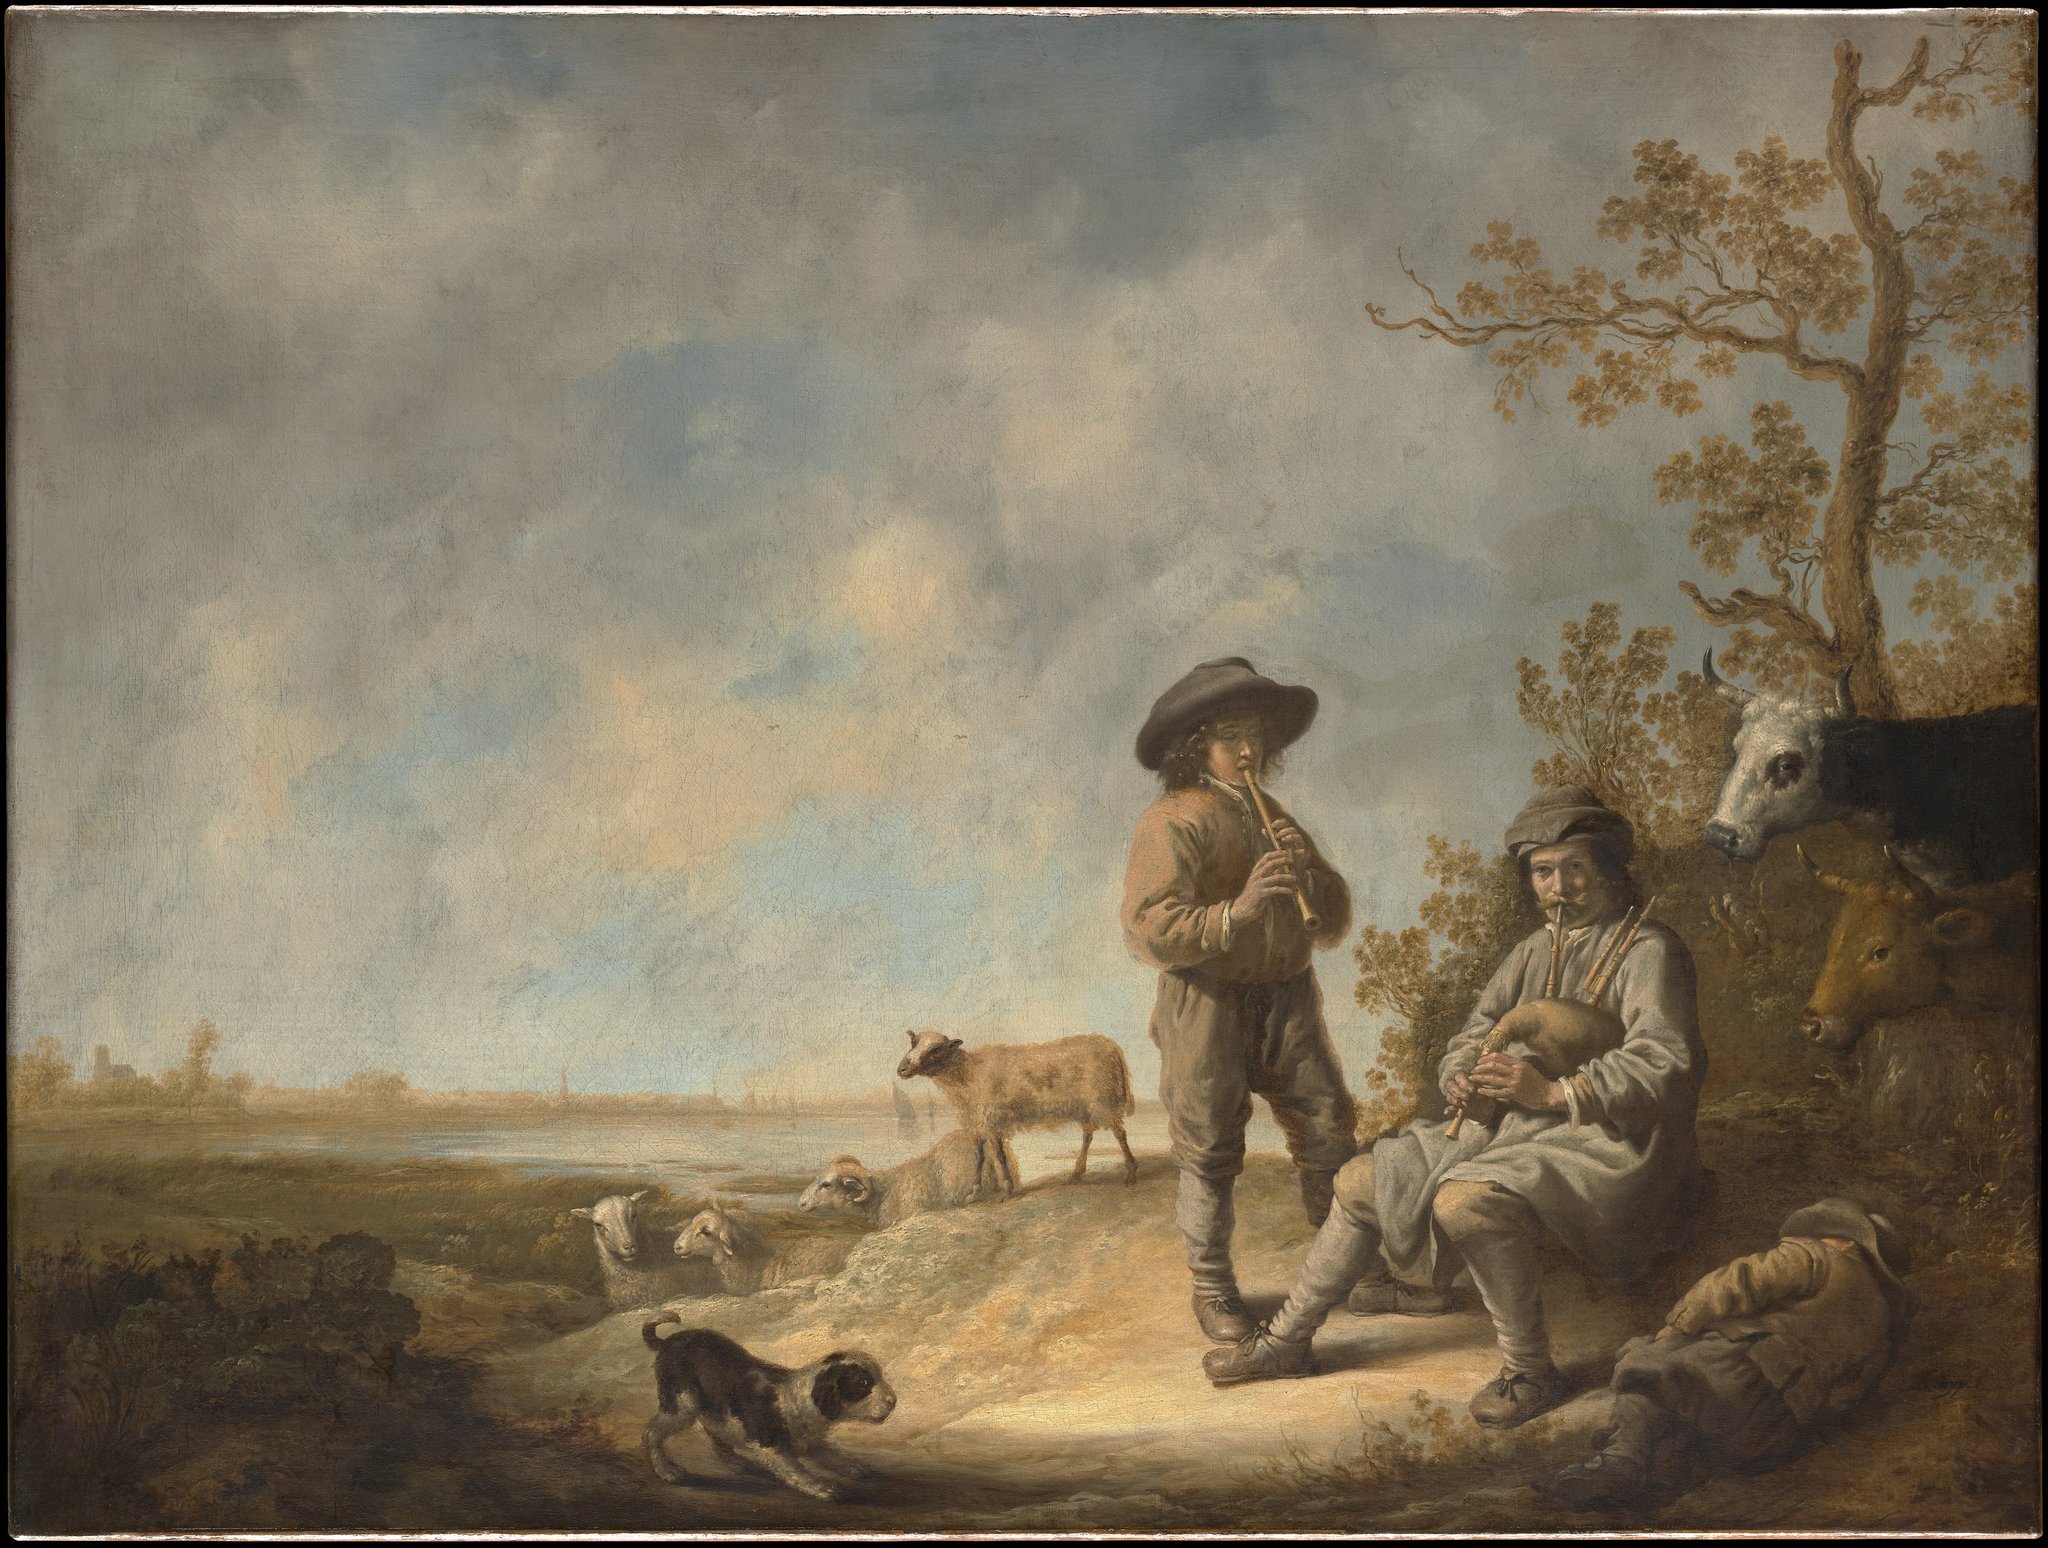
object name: painting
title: Piping Shepherds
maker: aelbert cuyp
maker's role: artist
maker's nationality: dutch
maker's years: 1620-1691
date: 1643-1644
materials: canvas, oil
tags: bagpipes,flutes,cows,dogs,sheep,shepherds